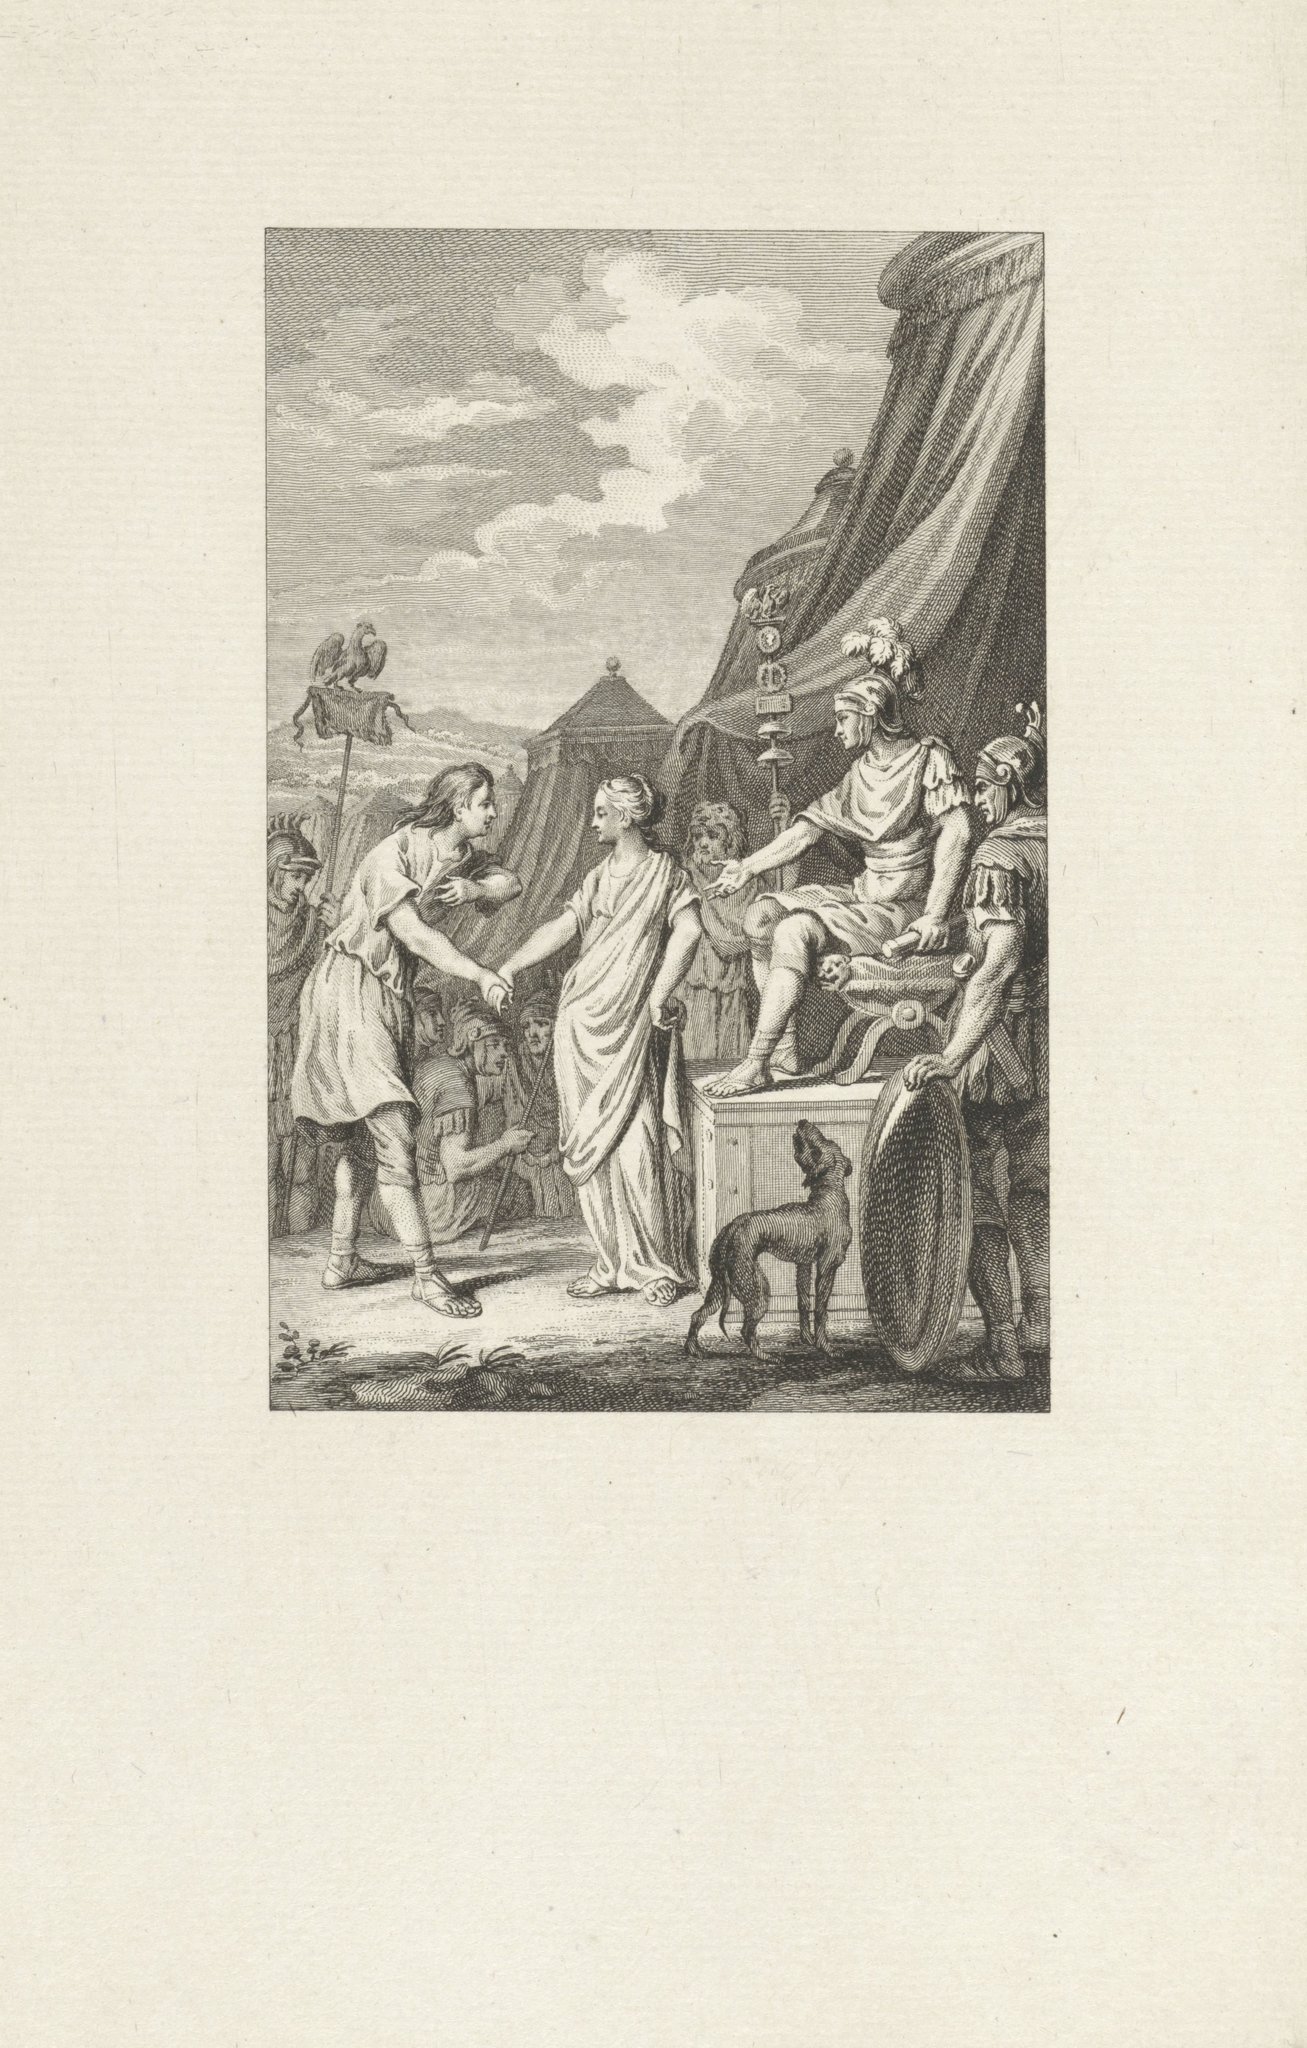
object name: print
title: Scipio en de bruid van Numantia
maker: reinier vinkeles (i)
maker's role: draughtsman, print maker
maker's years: 1741-1816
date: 1781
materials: paper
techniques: engraving, etching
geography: amsterdam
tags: politician, adolescent, young woman, maiden, (military) camp with tents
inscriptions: collector's mark: Lugt 240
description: Latere staat prent gebruikt als boekillustratie in: Martinet, Joannes Florentius. Historie der waereld. Amsterdam: Johannes Allart, 1780-1788. 25 delen. deel II, pl. II.